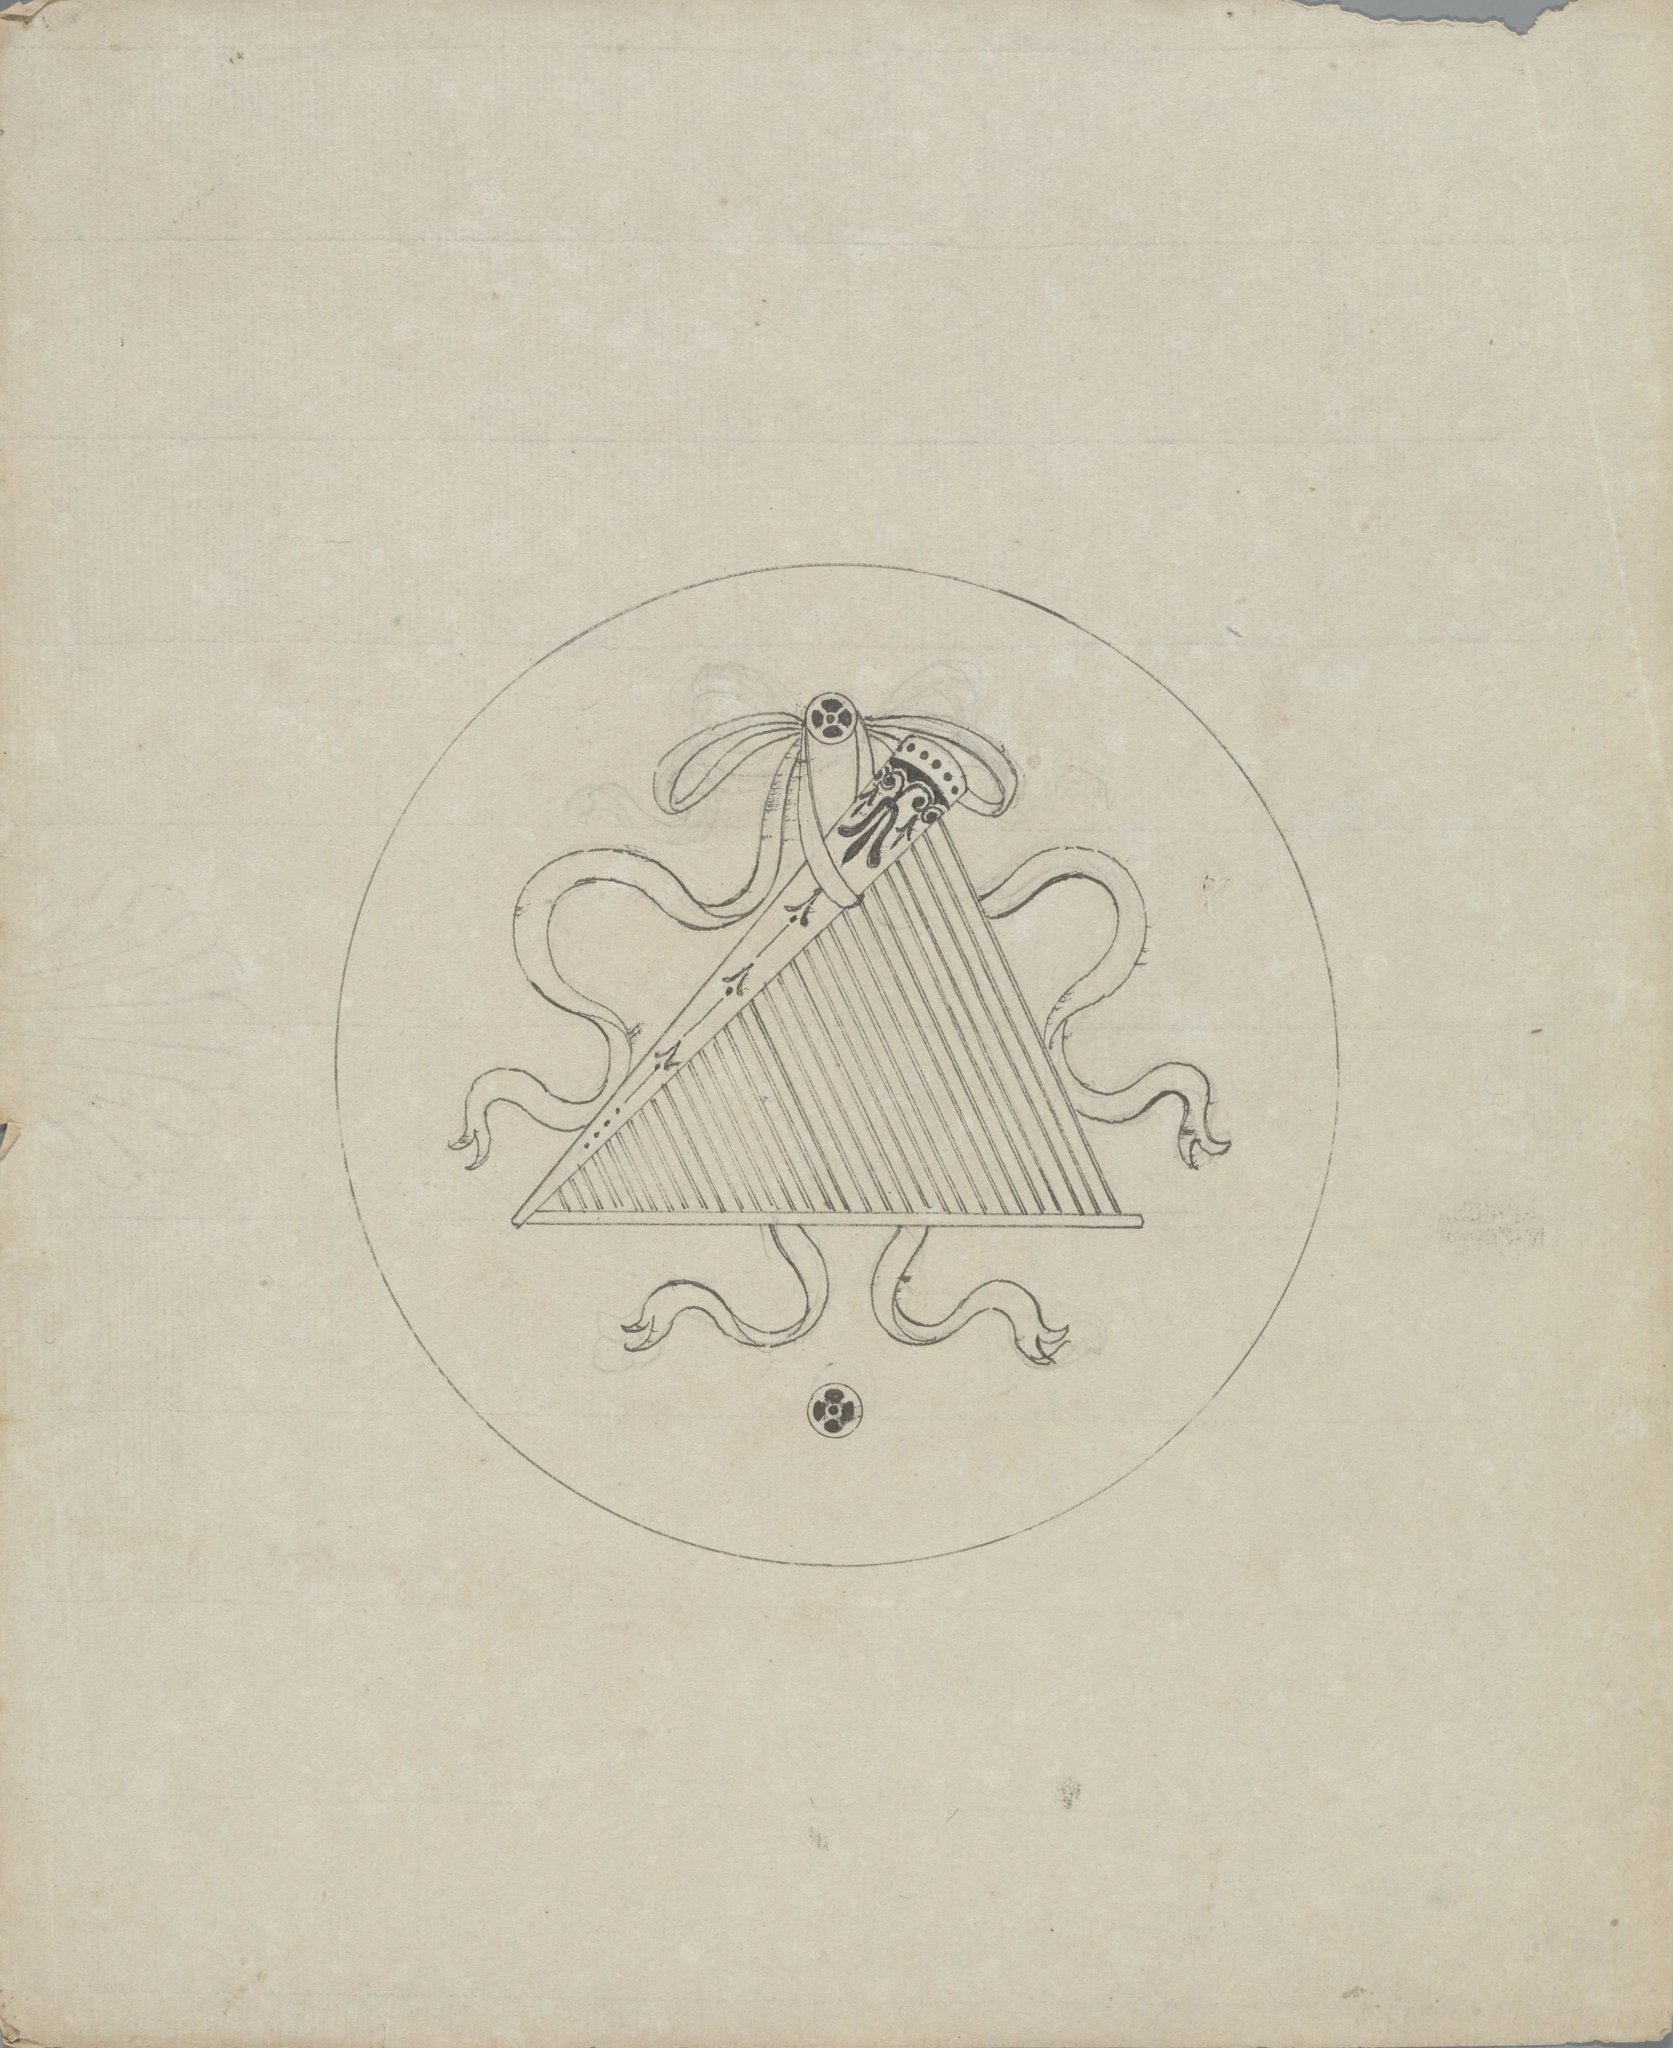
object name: design drawing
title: Snaarinstrument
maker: pierre félix van doren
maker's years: 1797-1856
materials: graphite, ink, paper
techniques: pen in black ink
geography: brussels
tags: trophy, i.e.: decorative arrangement of symbolic or typical objects ~ ornament, string instruments (plucked)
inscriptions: watermark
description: Een van 103 ontwerpen voor marqueterie van aan linten opgehangen muziekinstrumenten in ronde medaillons, bestemd voor de set stoelen gemaakt door Van Doren voor de grote zaal van het Paleis van de Prins van Oranje in Brussel in 1828.